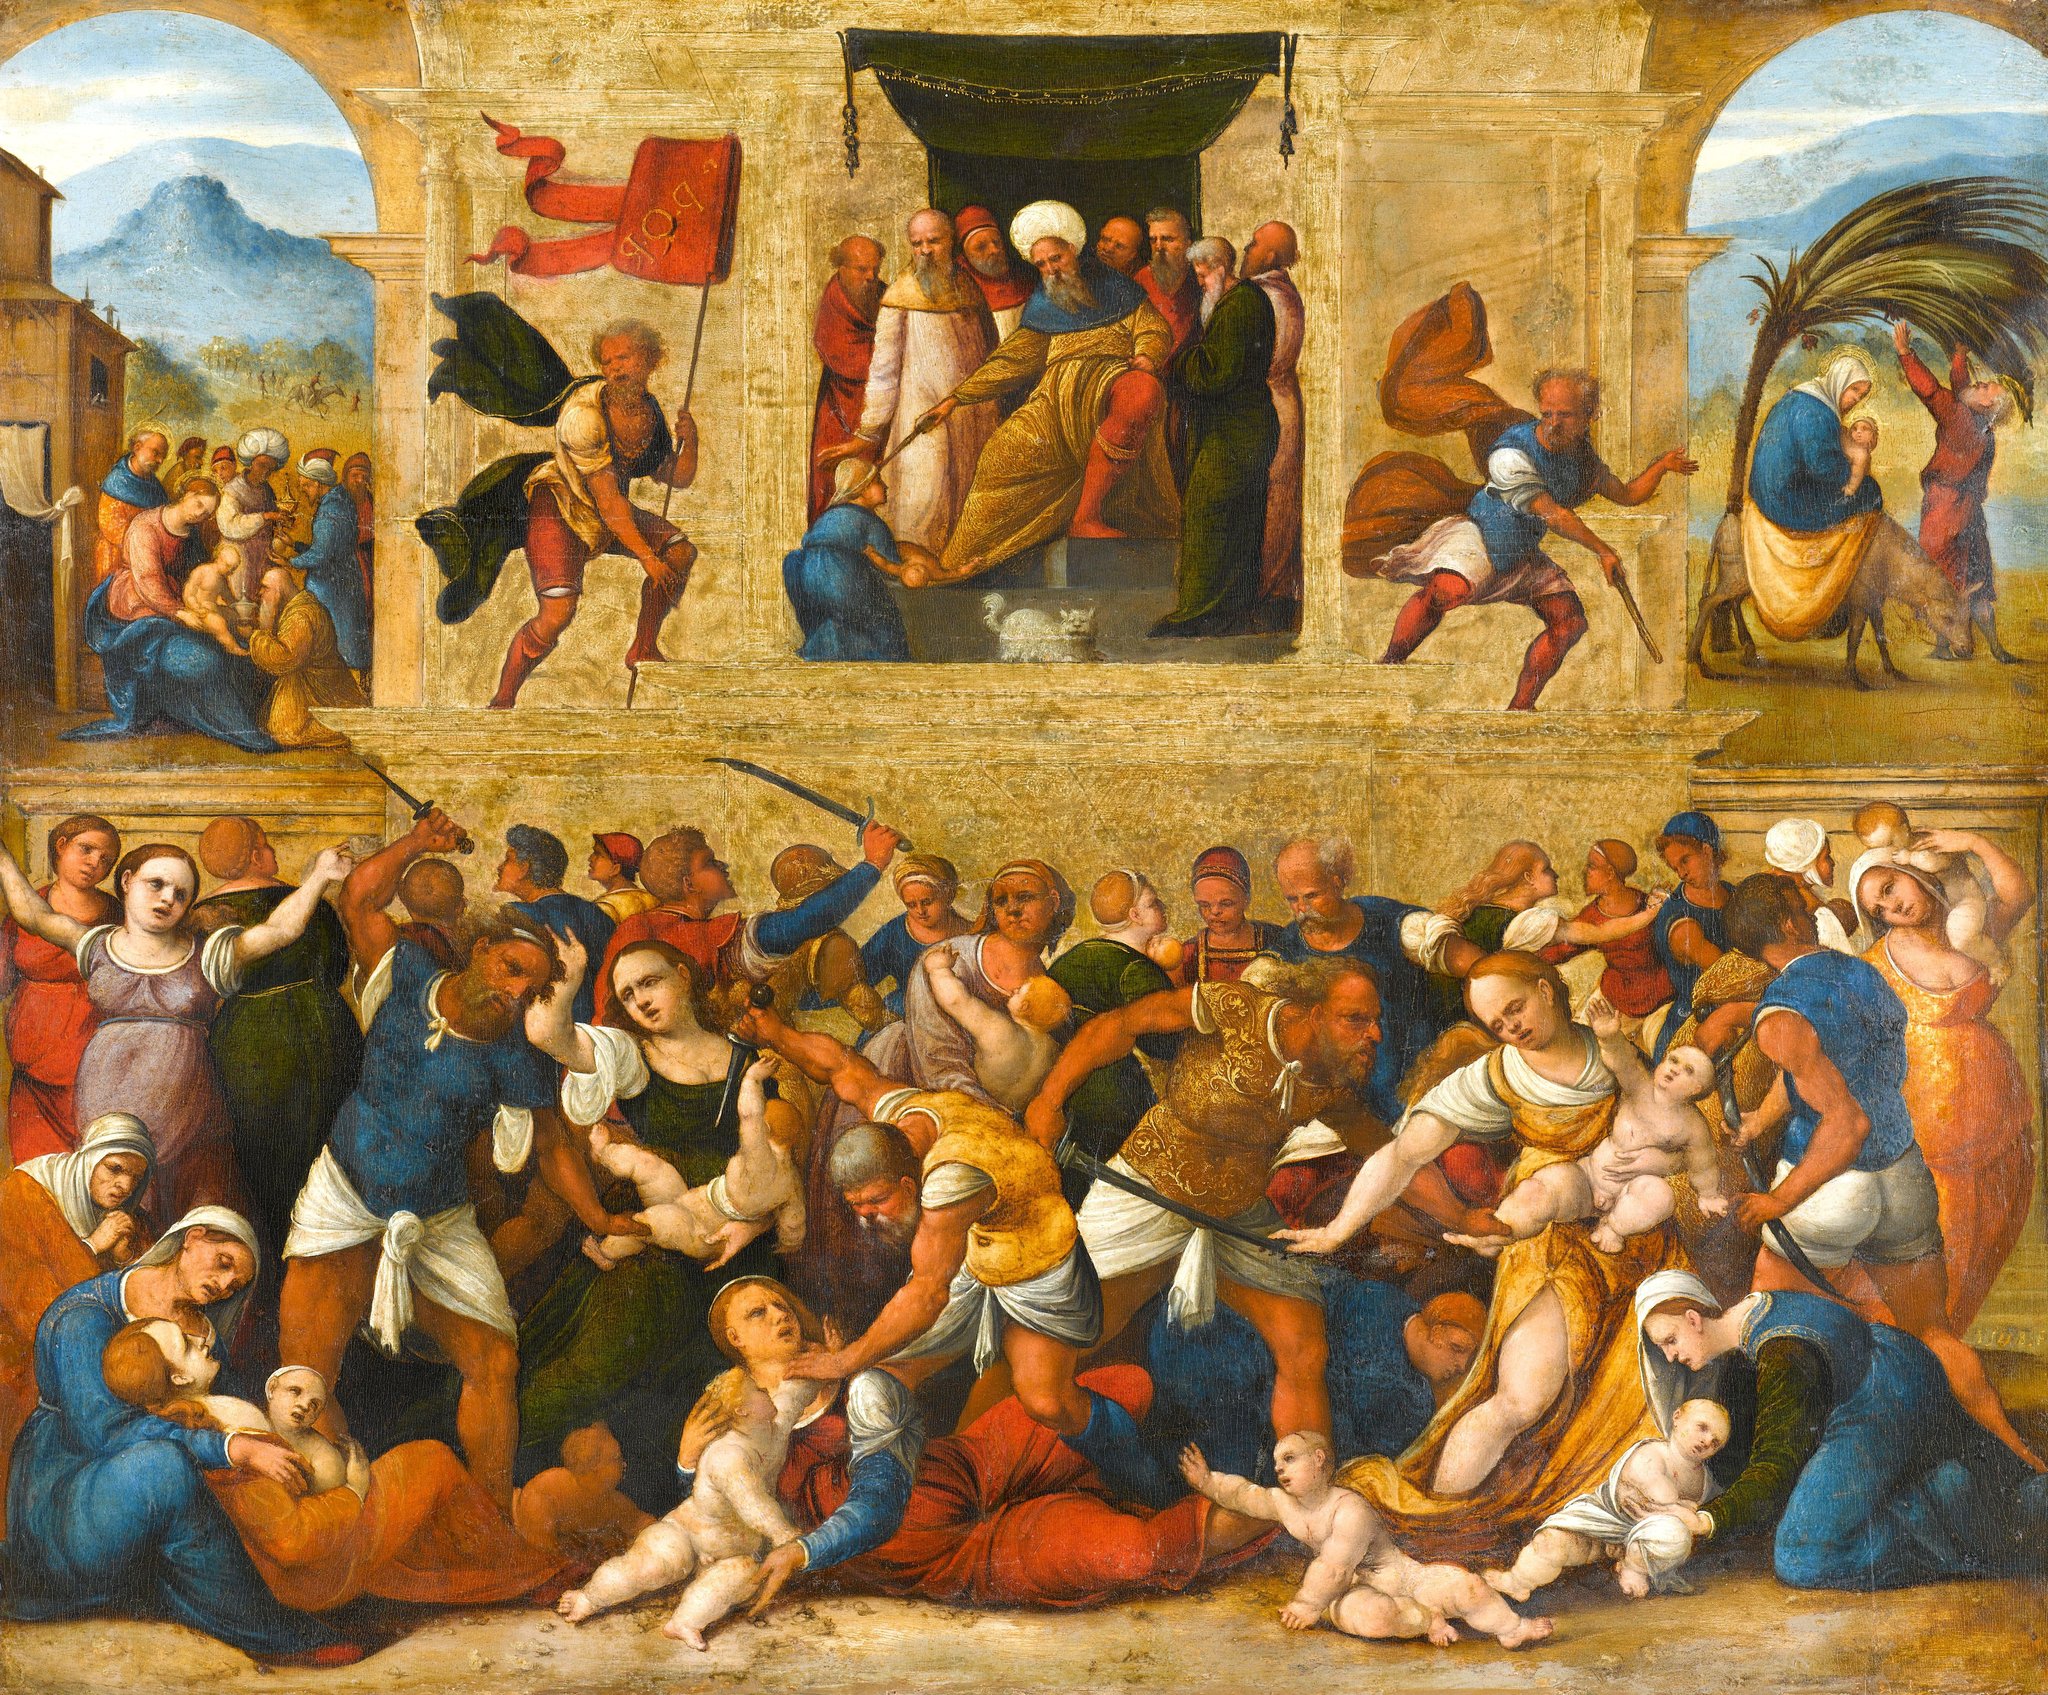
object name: painting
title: Massacre of the Innocents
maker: lodovico mazzolino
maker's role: draughtsman, painter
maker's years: 1480-1528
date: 1510-1530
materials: oil, panel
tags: the massacre of the innocents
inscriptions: inscription and date: ‘1548 FE’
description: Ludovico Mazzolino (1480 - 1528). Massacre of the Innocents, 1528. Purchased by King Willem I, 1821. On loan from the Mauritshuis, The Hague, 1948.